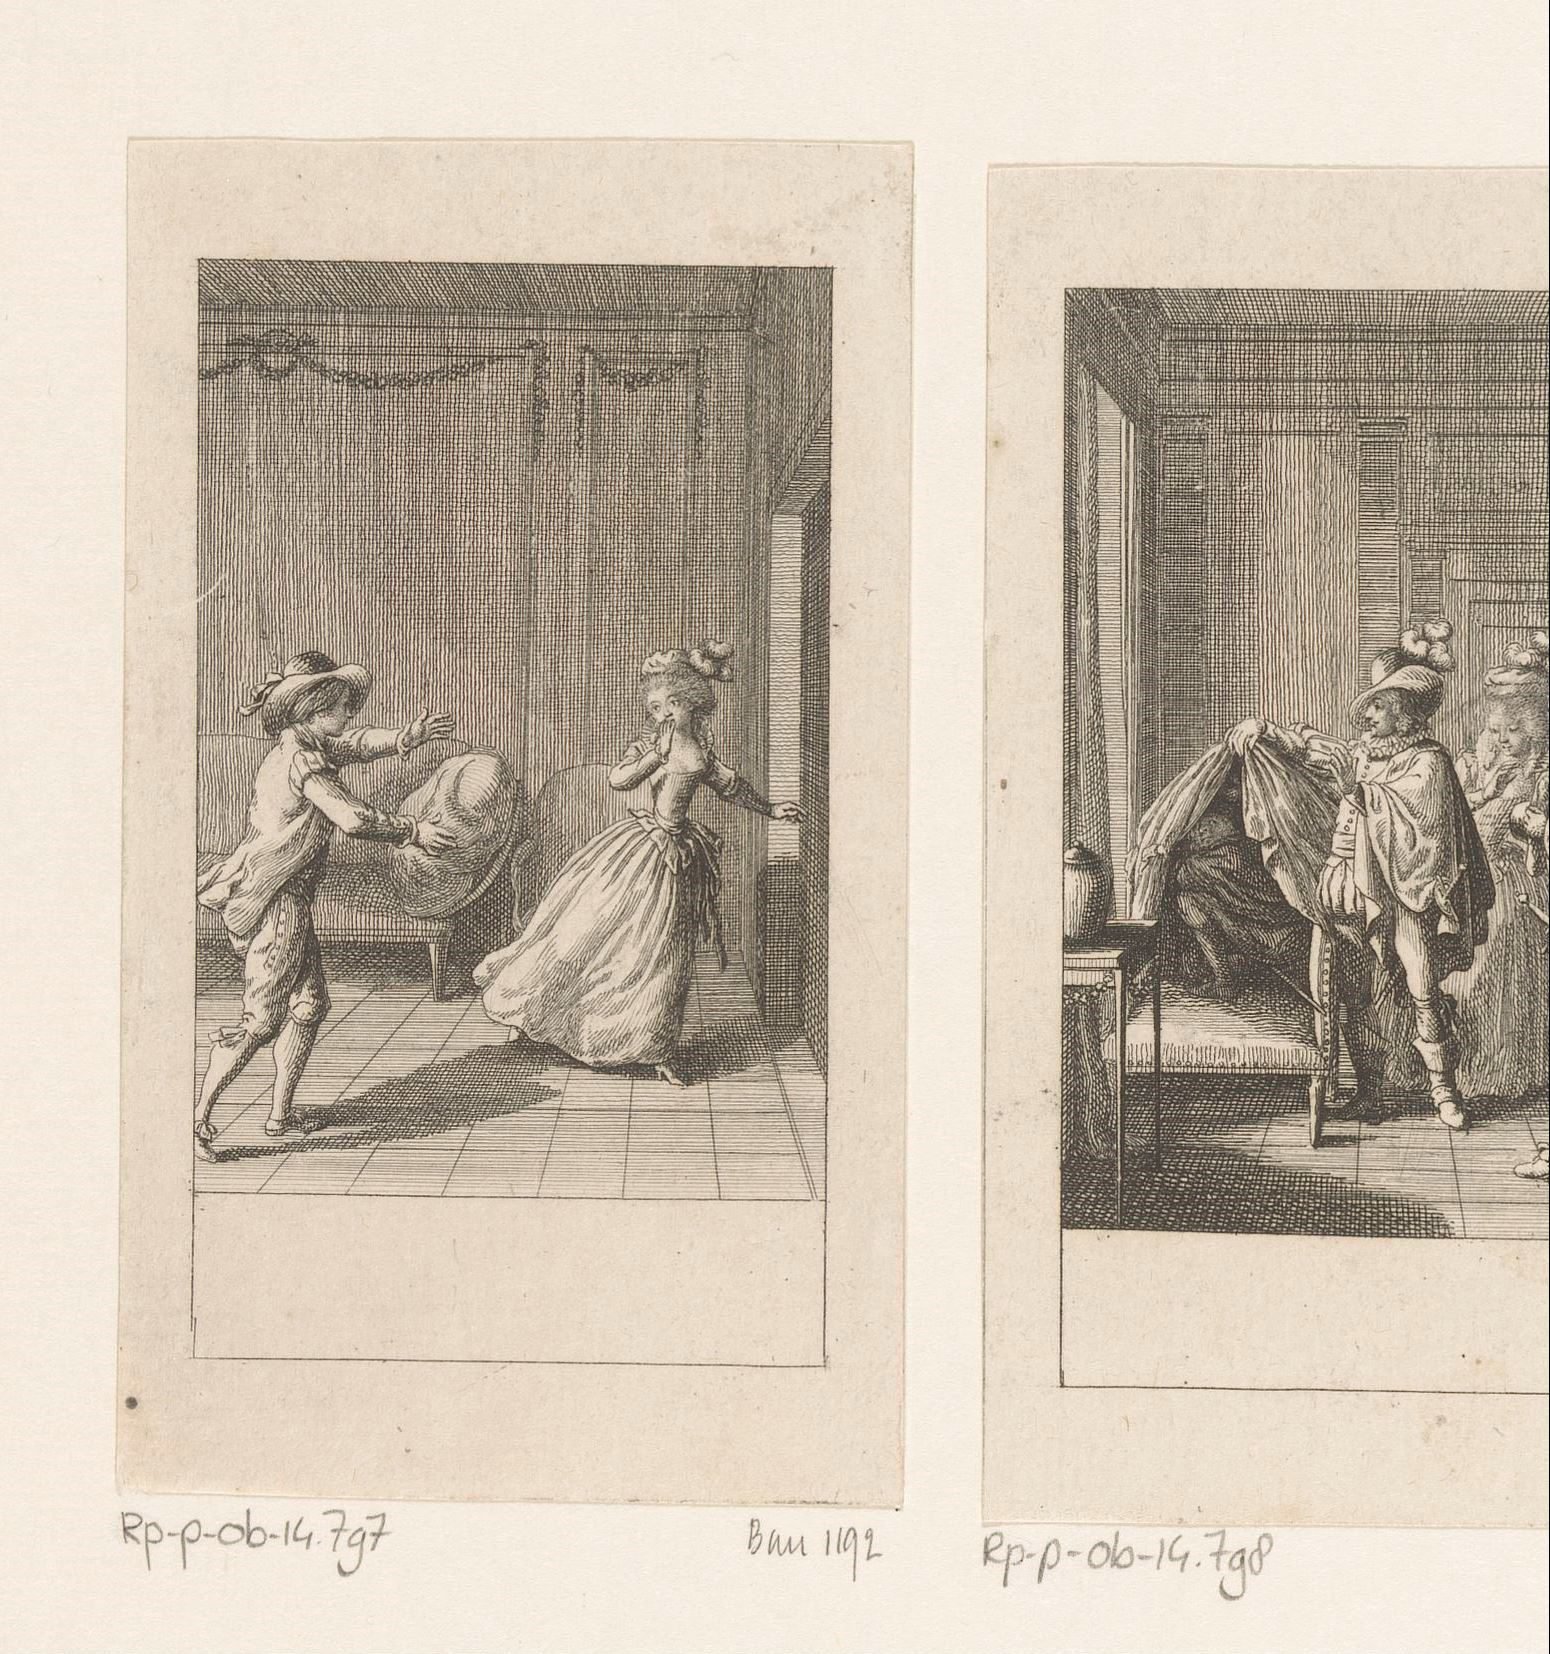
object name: print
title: Figaro vraagt Suzanne om een kus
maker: daniel nikolaus chodowiecki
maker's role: draughtsman, print maker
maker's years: 1726-1801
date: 1785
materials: paper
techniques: etching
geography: berlin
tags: paris, publisher, literature, parting, leave-taking (of lovers)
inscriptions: collector's mark: Lugt 2228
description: Vervaardigd voor 'le Mariage de Figaro' van Pierre Augustin Caron de Beaumarchais. Latere staat gebruikt voor: Almanac de Gotha contenant diverses connoissances curieuses et utiles pour l'année (...). Gotha: C. W. Ettinger, 1785.